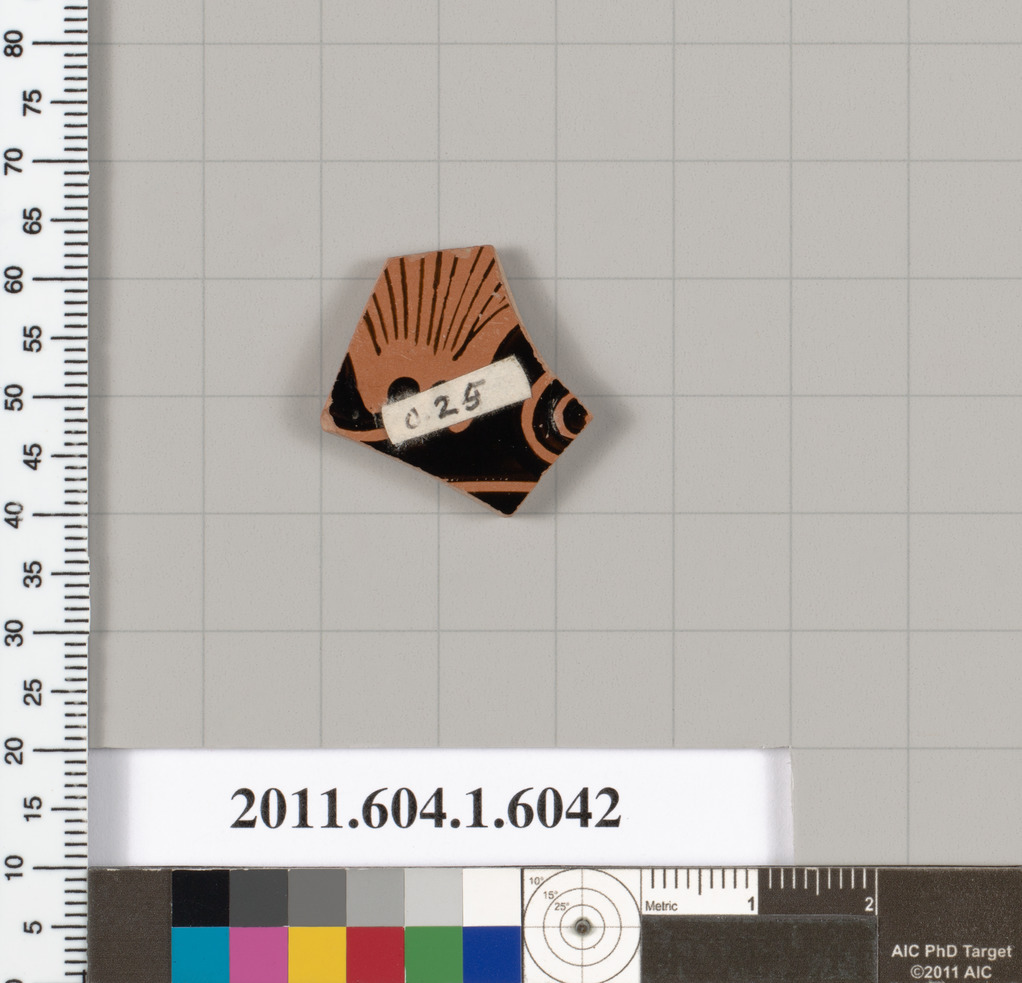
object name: kylix fragment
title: Terracotta fragment of a kylix (drinking cup)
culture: greek, attic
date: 510-500 BCE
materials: terracotta